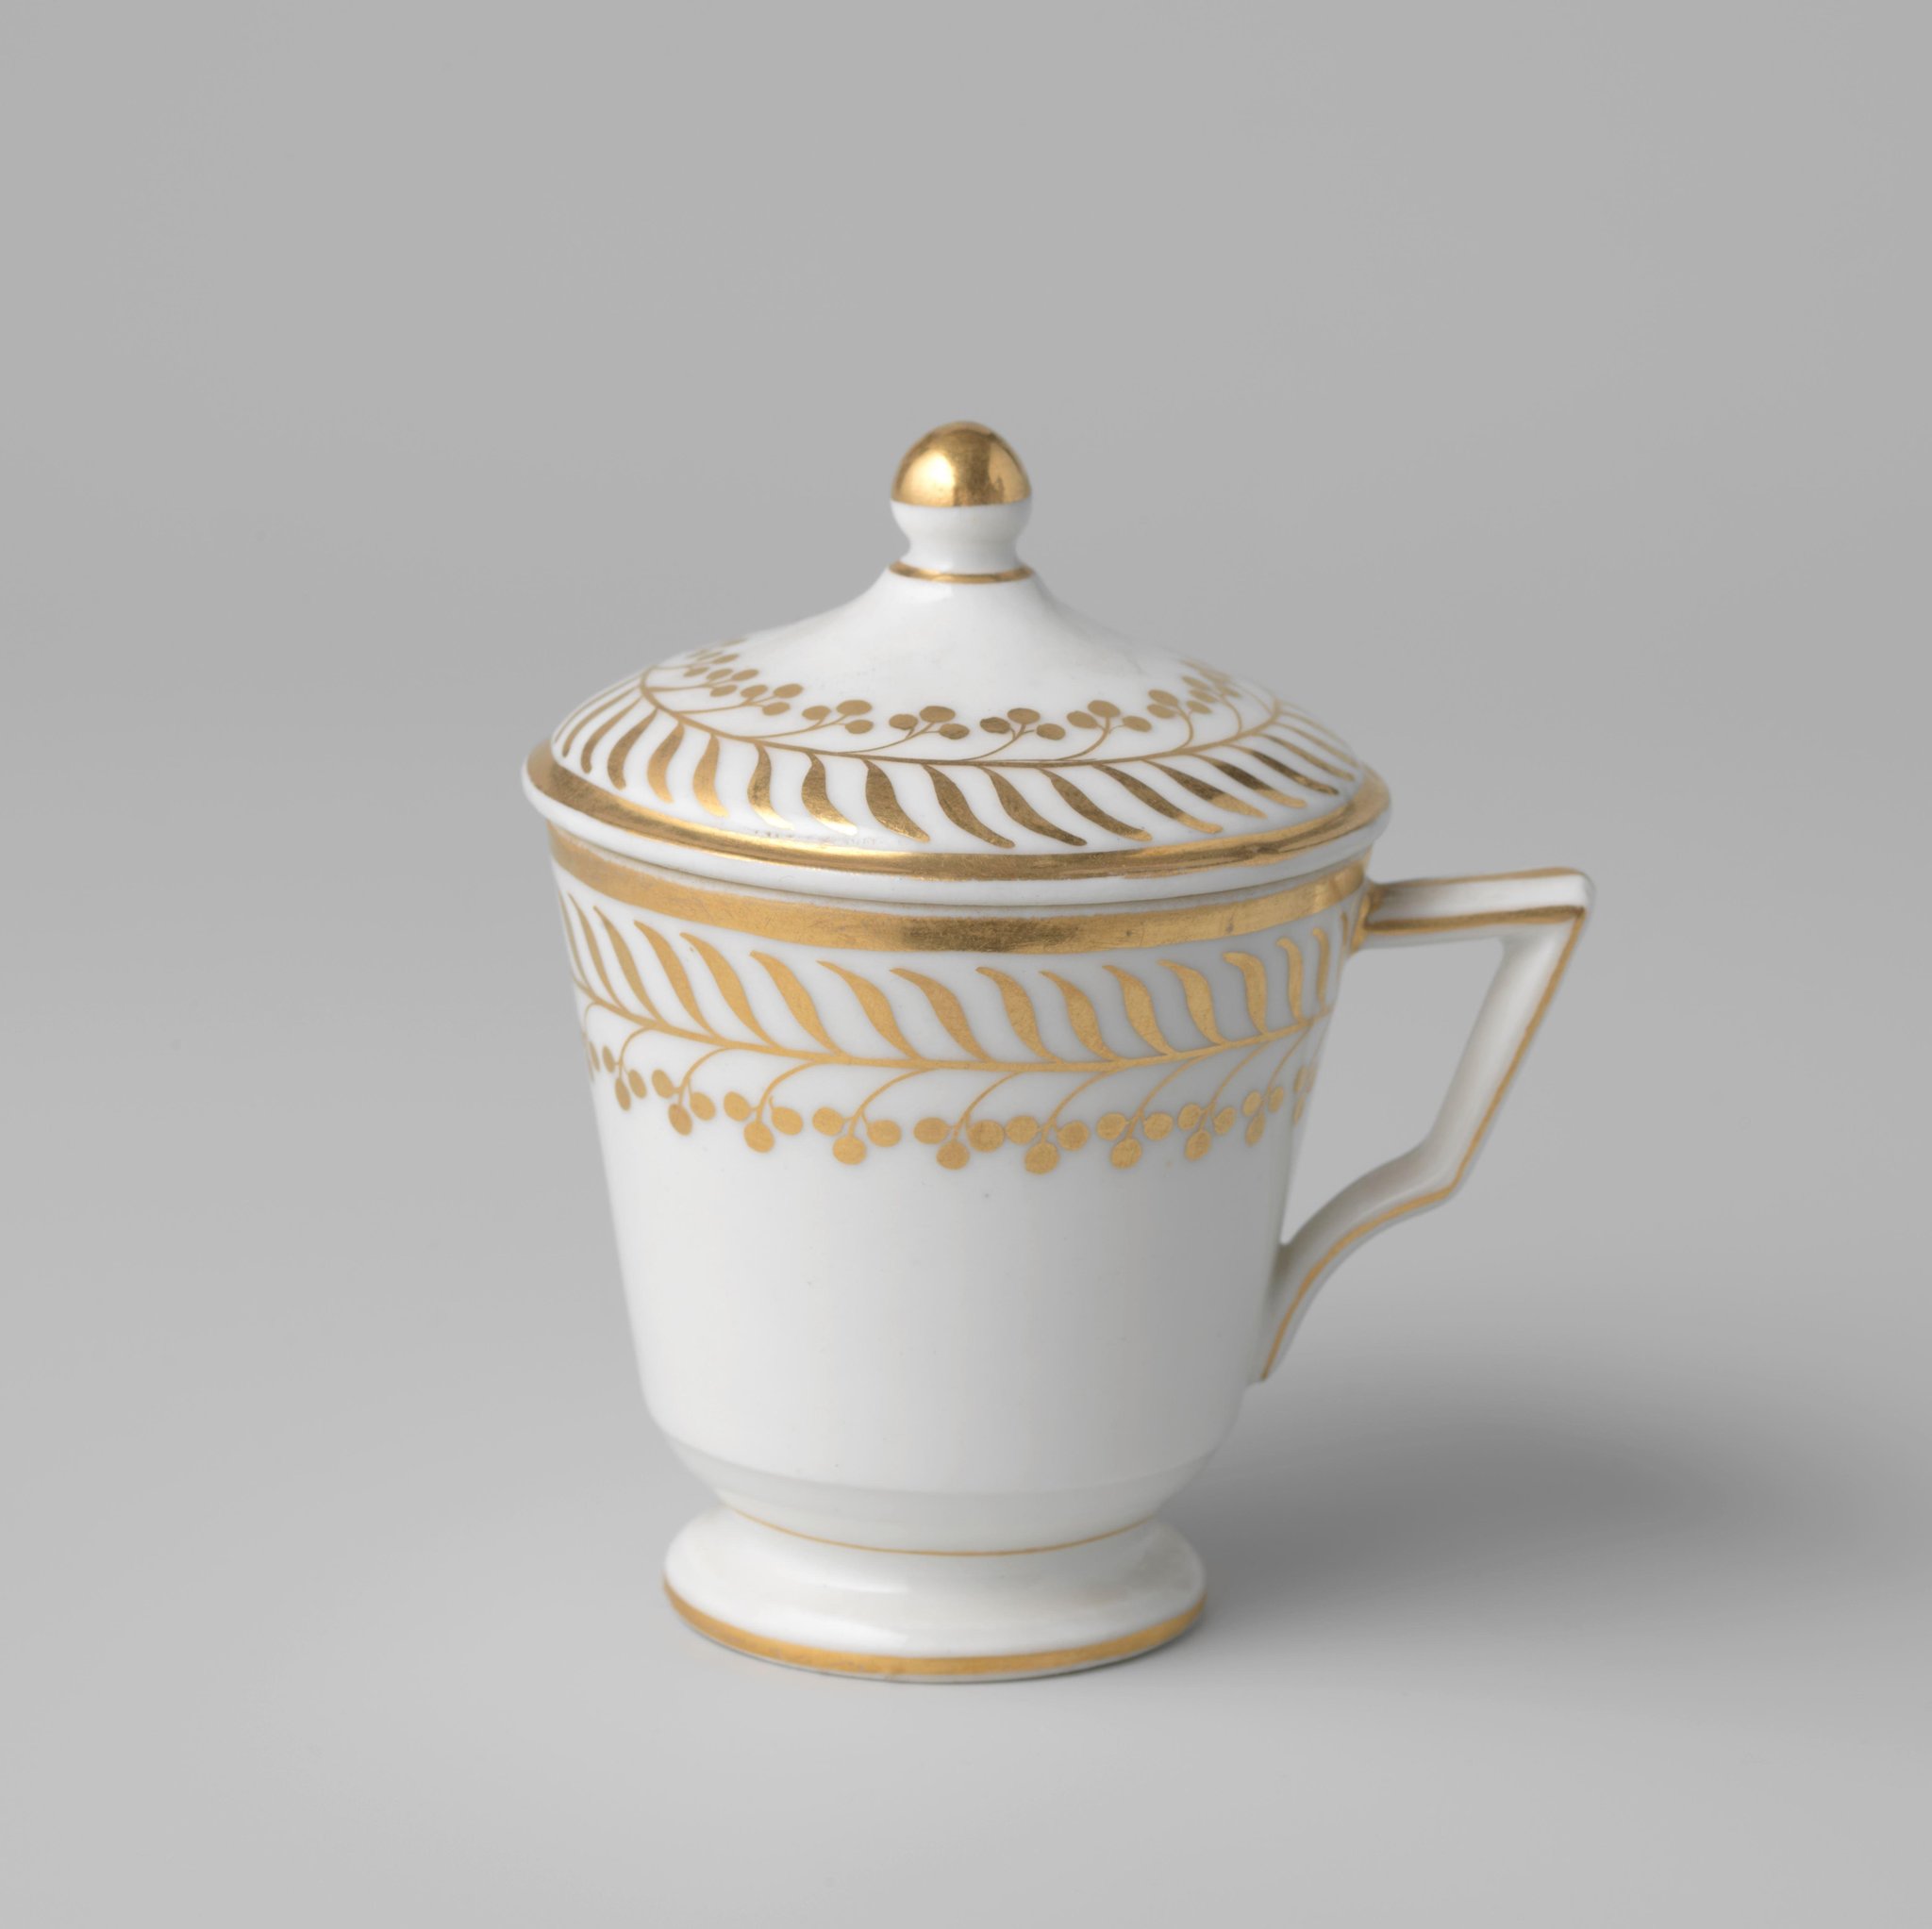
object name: service set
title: Covered cup (pot de crème) with stylized floral scrolls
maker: Anonymous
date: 1800-1810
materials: glaze, gold, paint, porcelain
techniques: firing, forming, gilding, vitrification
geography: france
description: Crêmepot van porselein, met oor en deksel waarop een vergulde knop. Versierd met gouden biezen en langs de randen beschilderd met een doorlopende tak met aan de ene zijde bladeren, aan de andere zijde steeds een tak met drie vruchten. Gemerkt met ingegrifte 1.